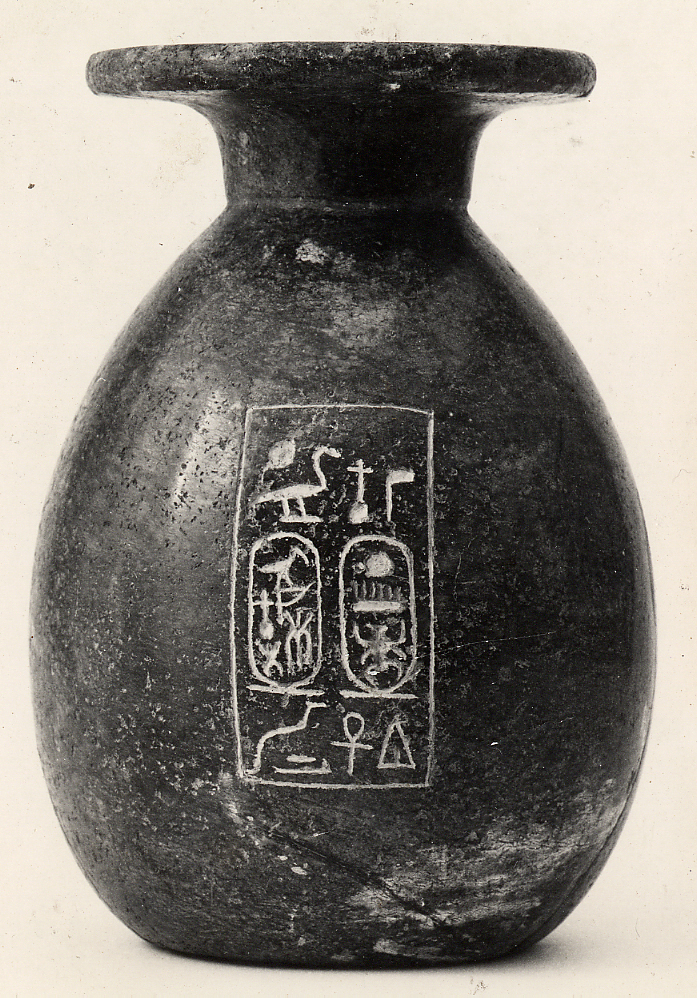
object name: jar, cartouch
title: Storage jar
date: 1479-1425 BCE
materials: stone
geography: egypt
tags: hieroglyphs